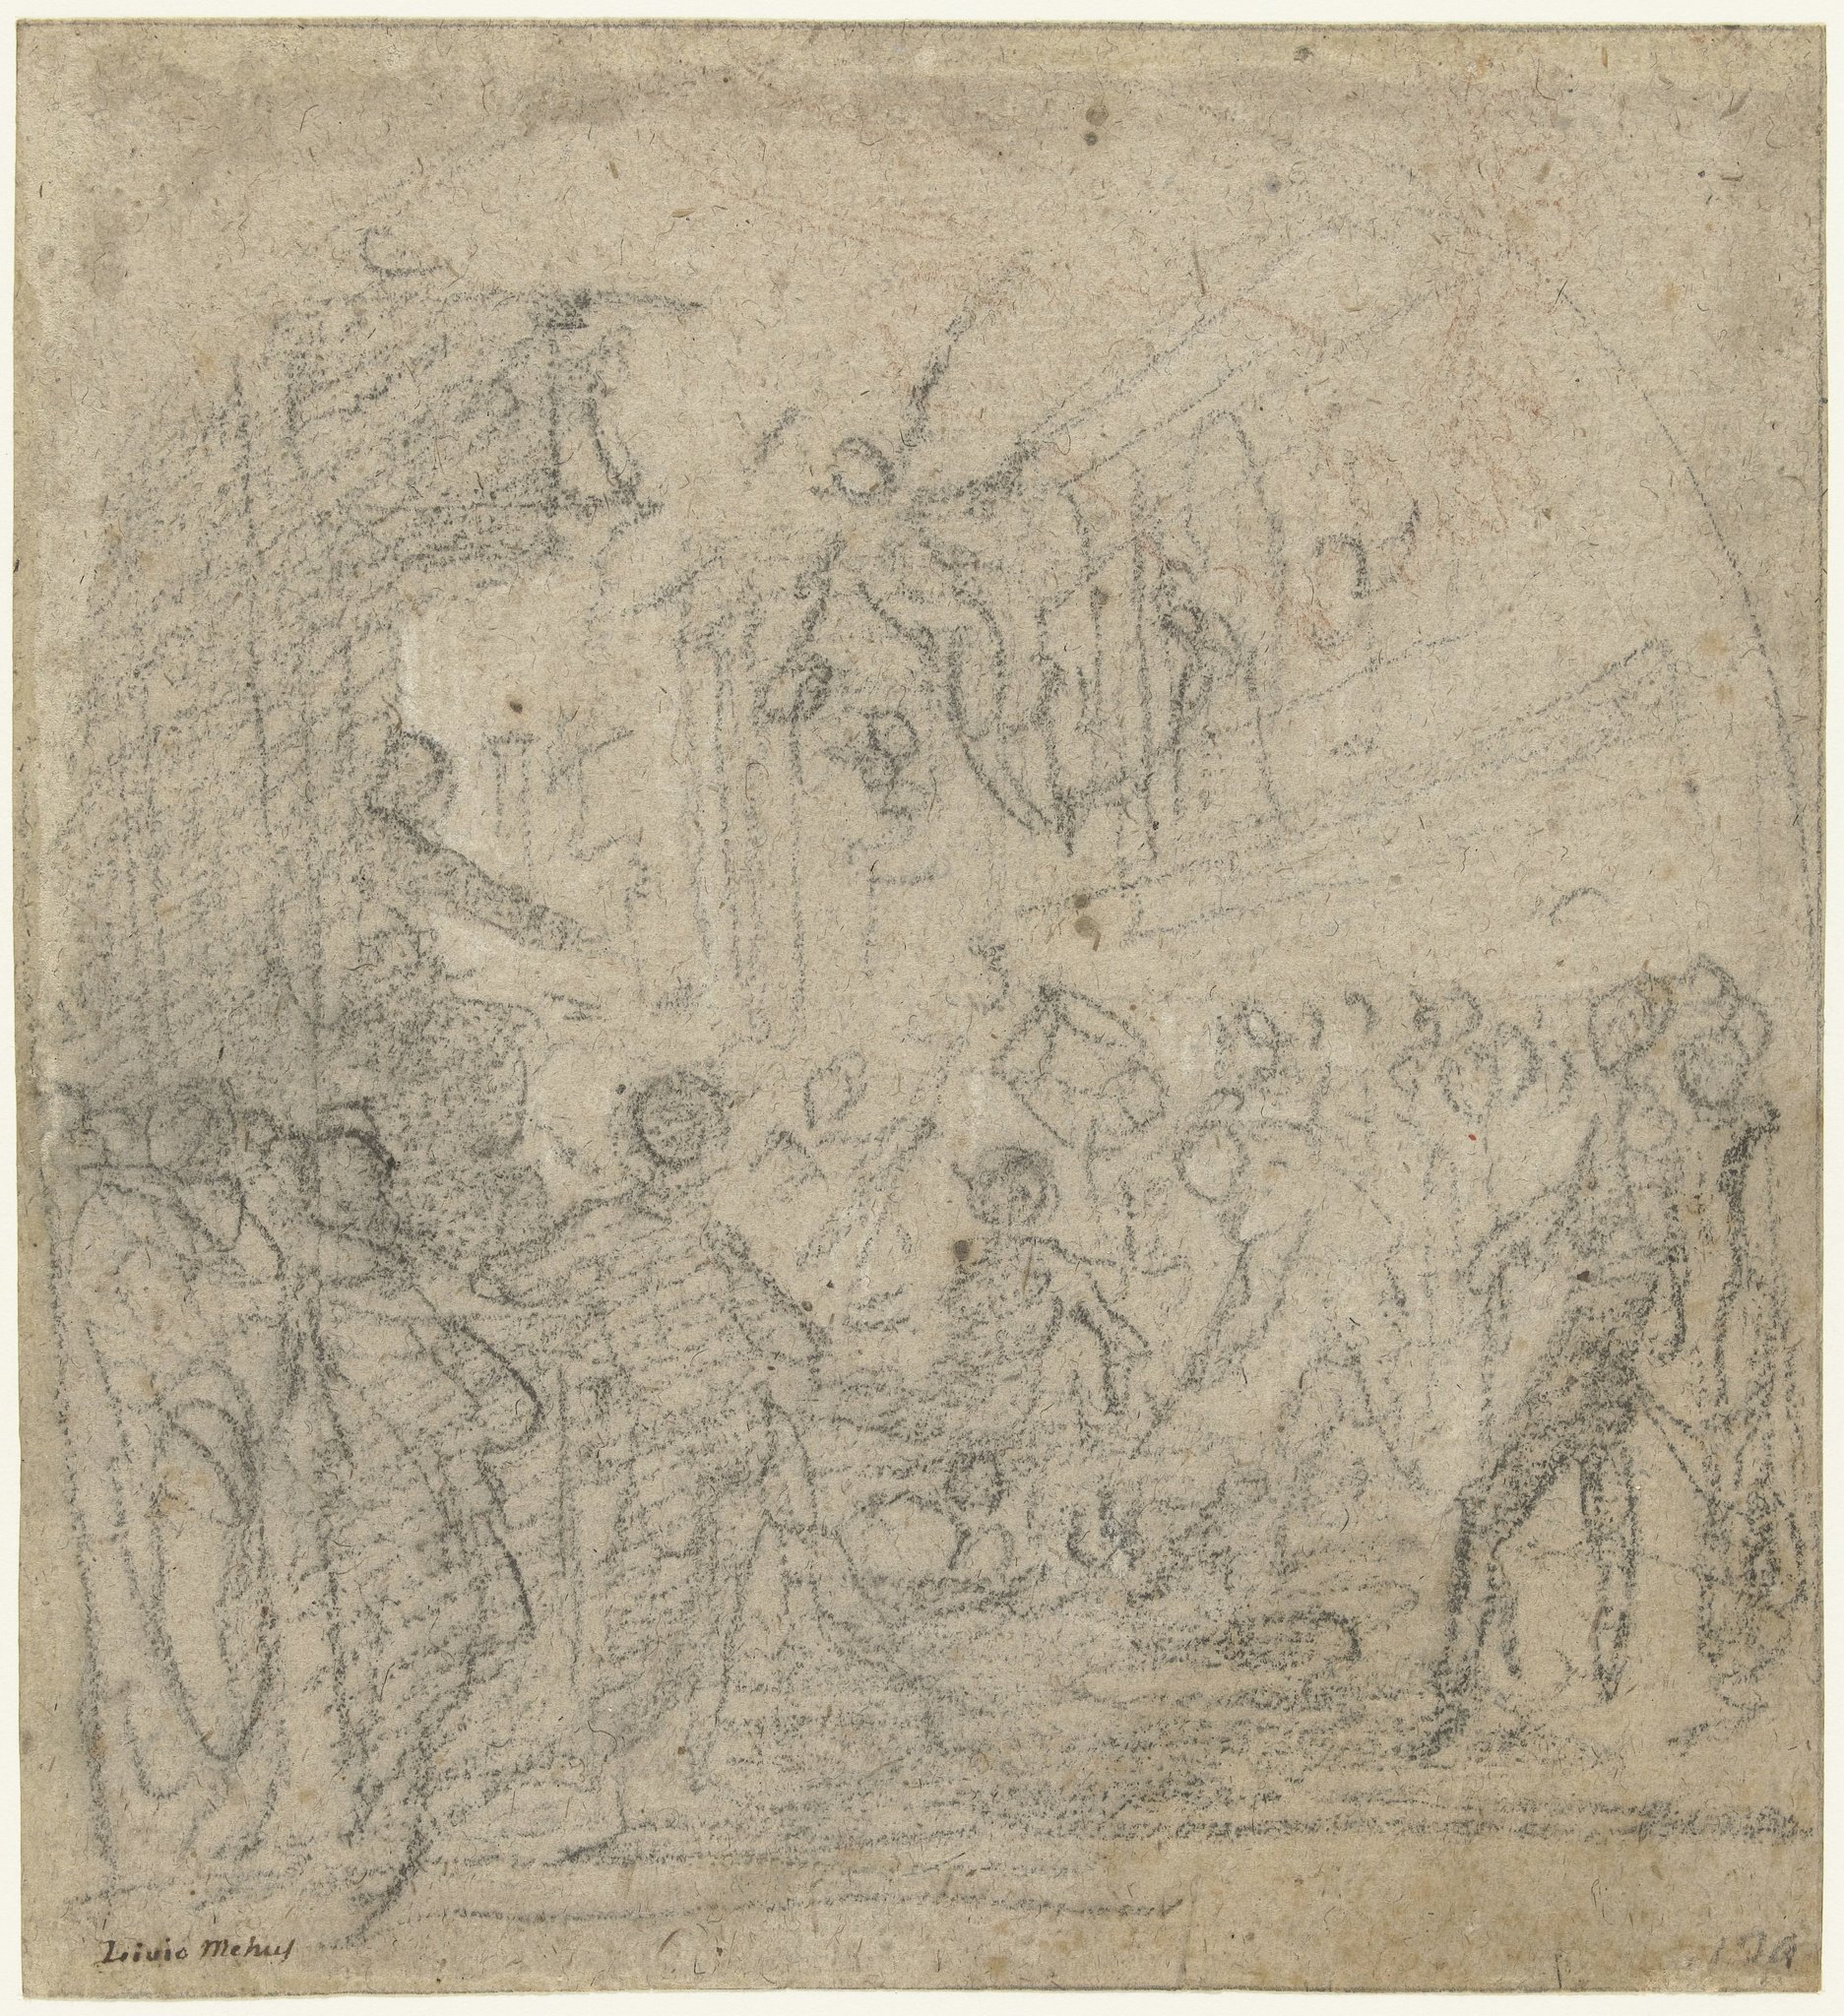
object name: drawing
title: De marteling van de Heilige Laurentius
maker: cristofano allori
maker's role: draughtsman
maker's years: 1577-1621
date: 1616-1621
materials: chalk, paper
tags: martyrdom, suffering, misfortune, death of st. laurence